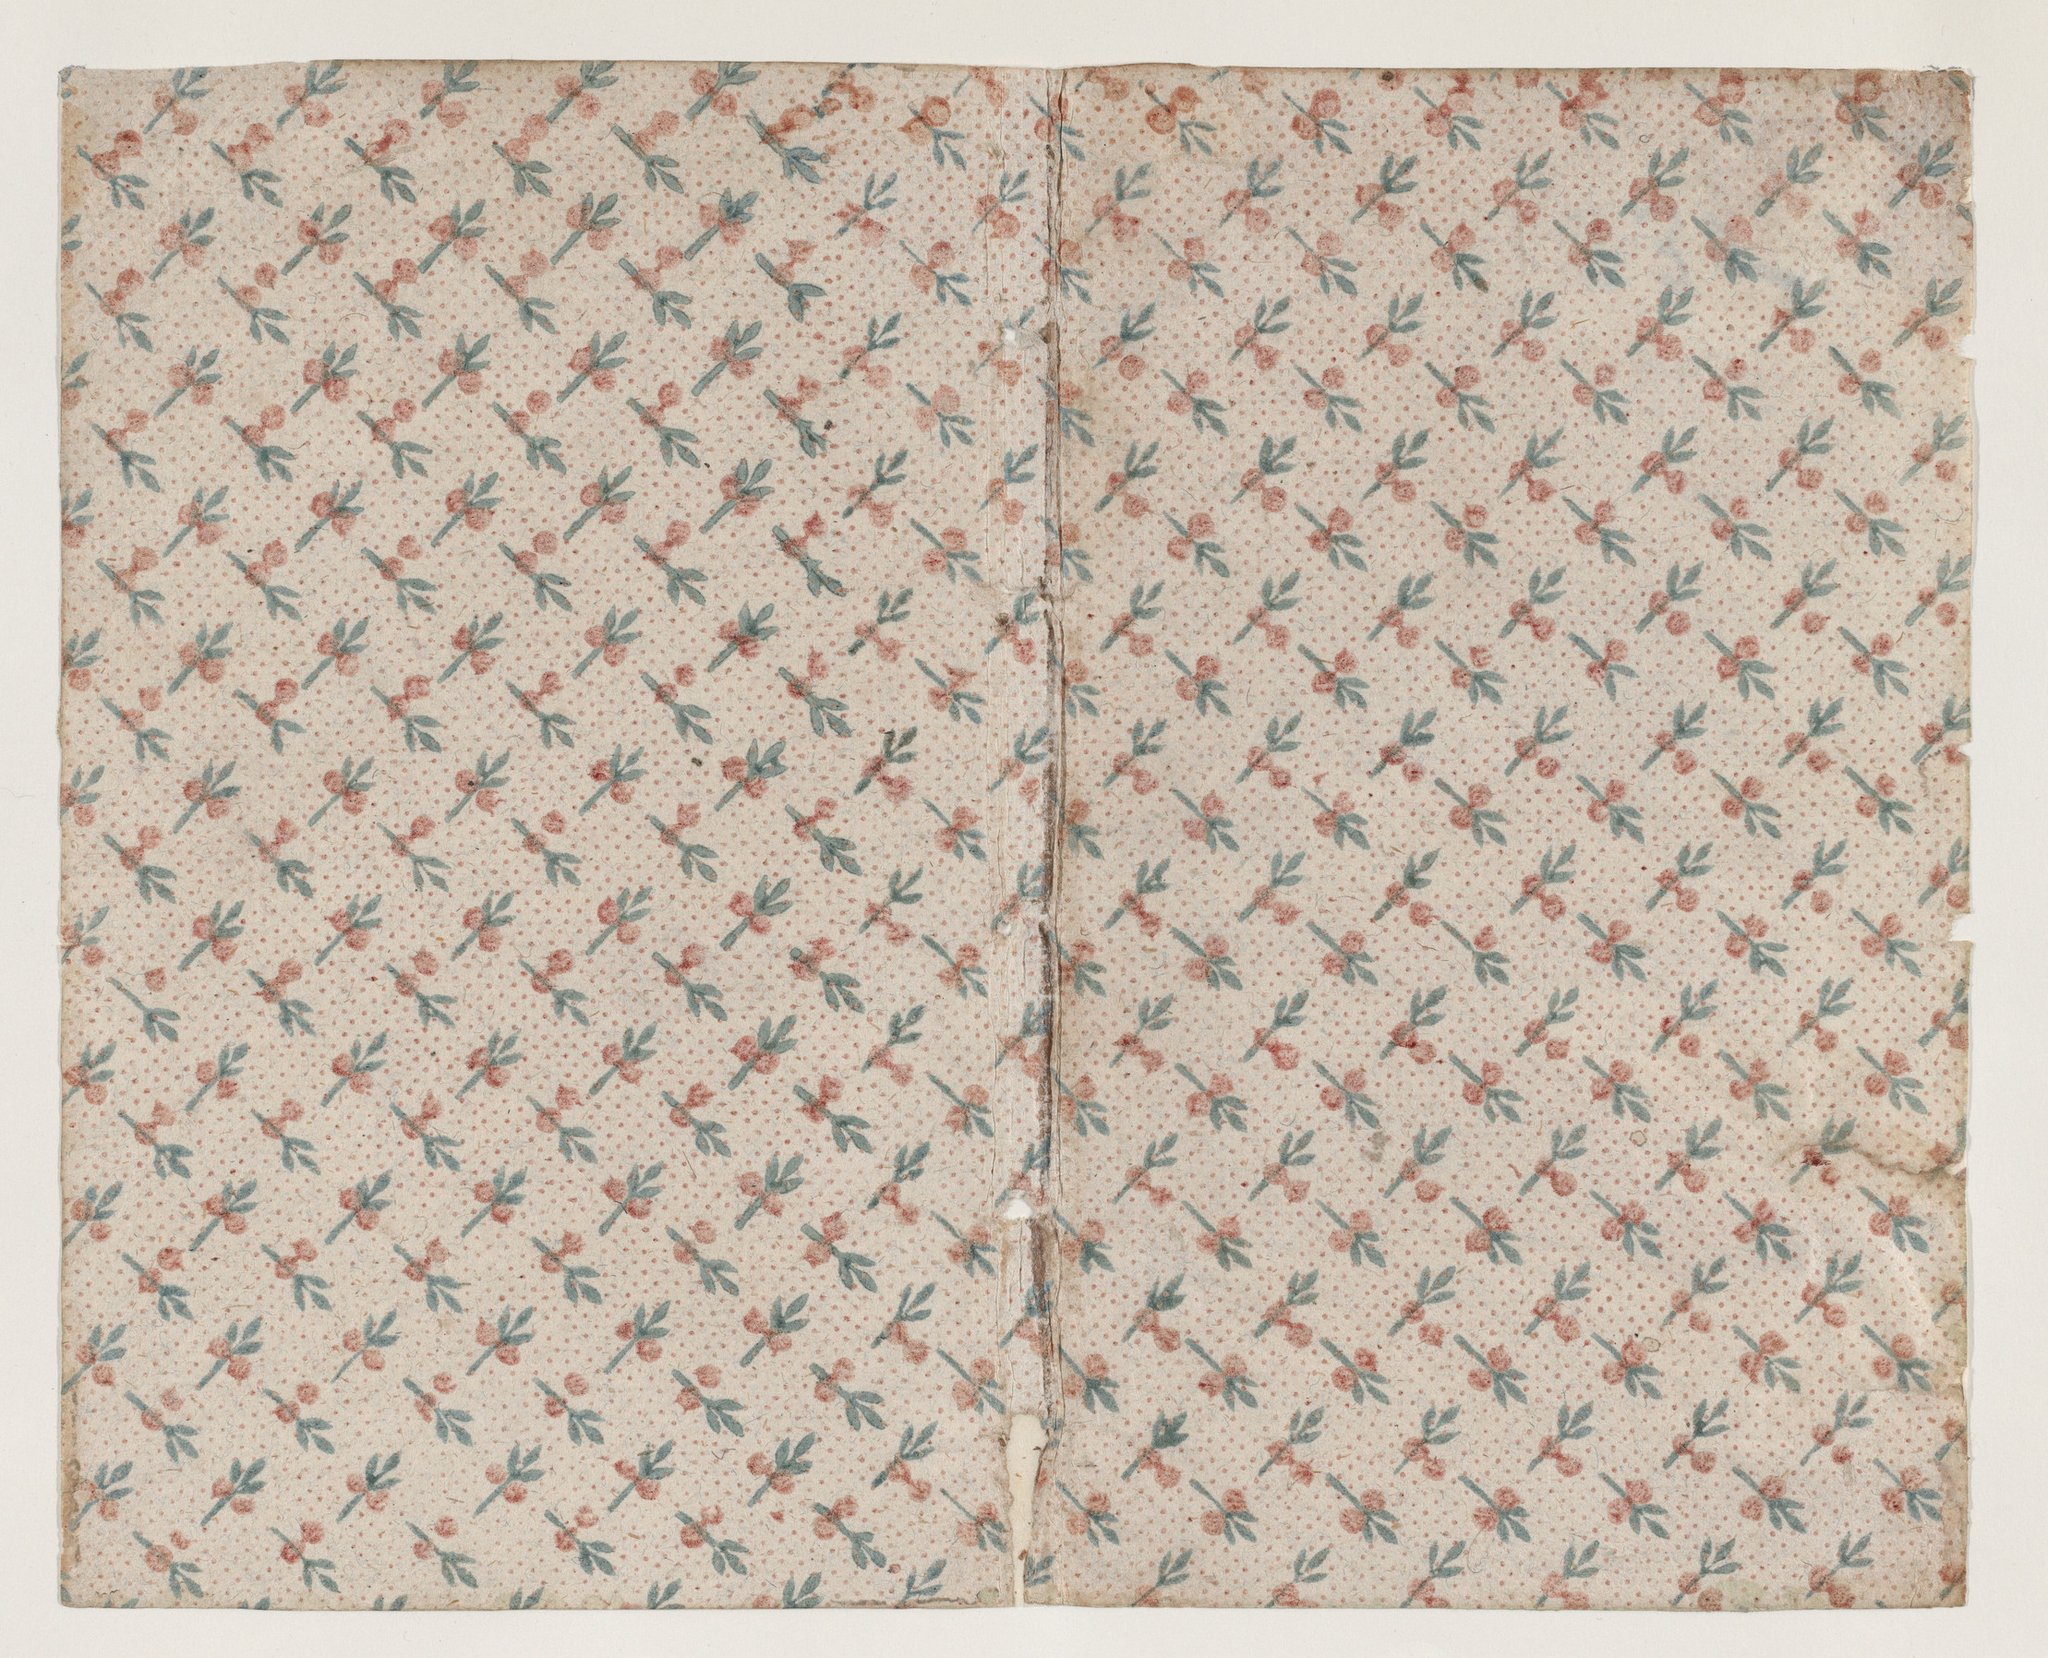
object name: print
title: Sheet with dot grid pattern with bouquets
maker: Anonymous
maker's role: artist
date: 1801-1900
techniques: relief print